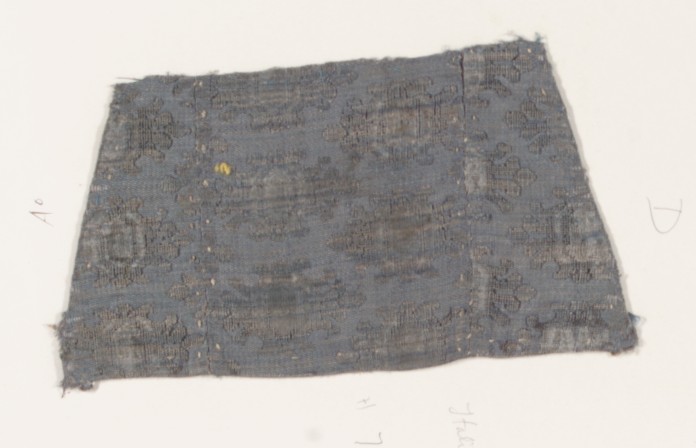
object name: fragment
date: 1501-1600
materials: silk